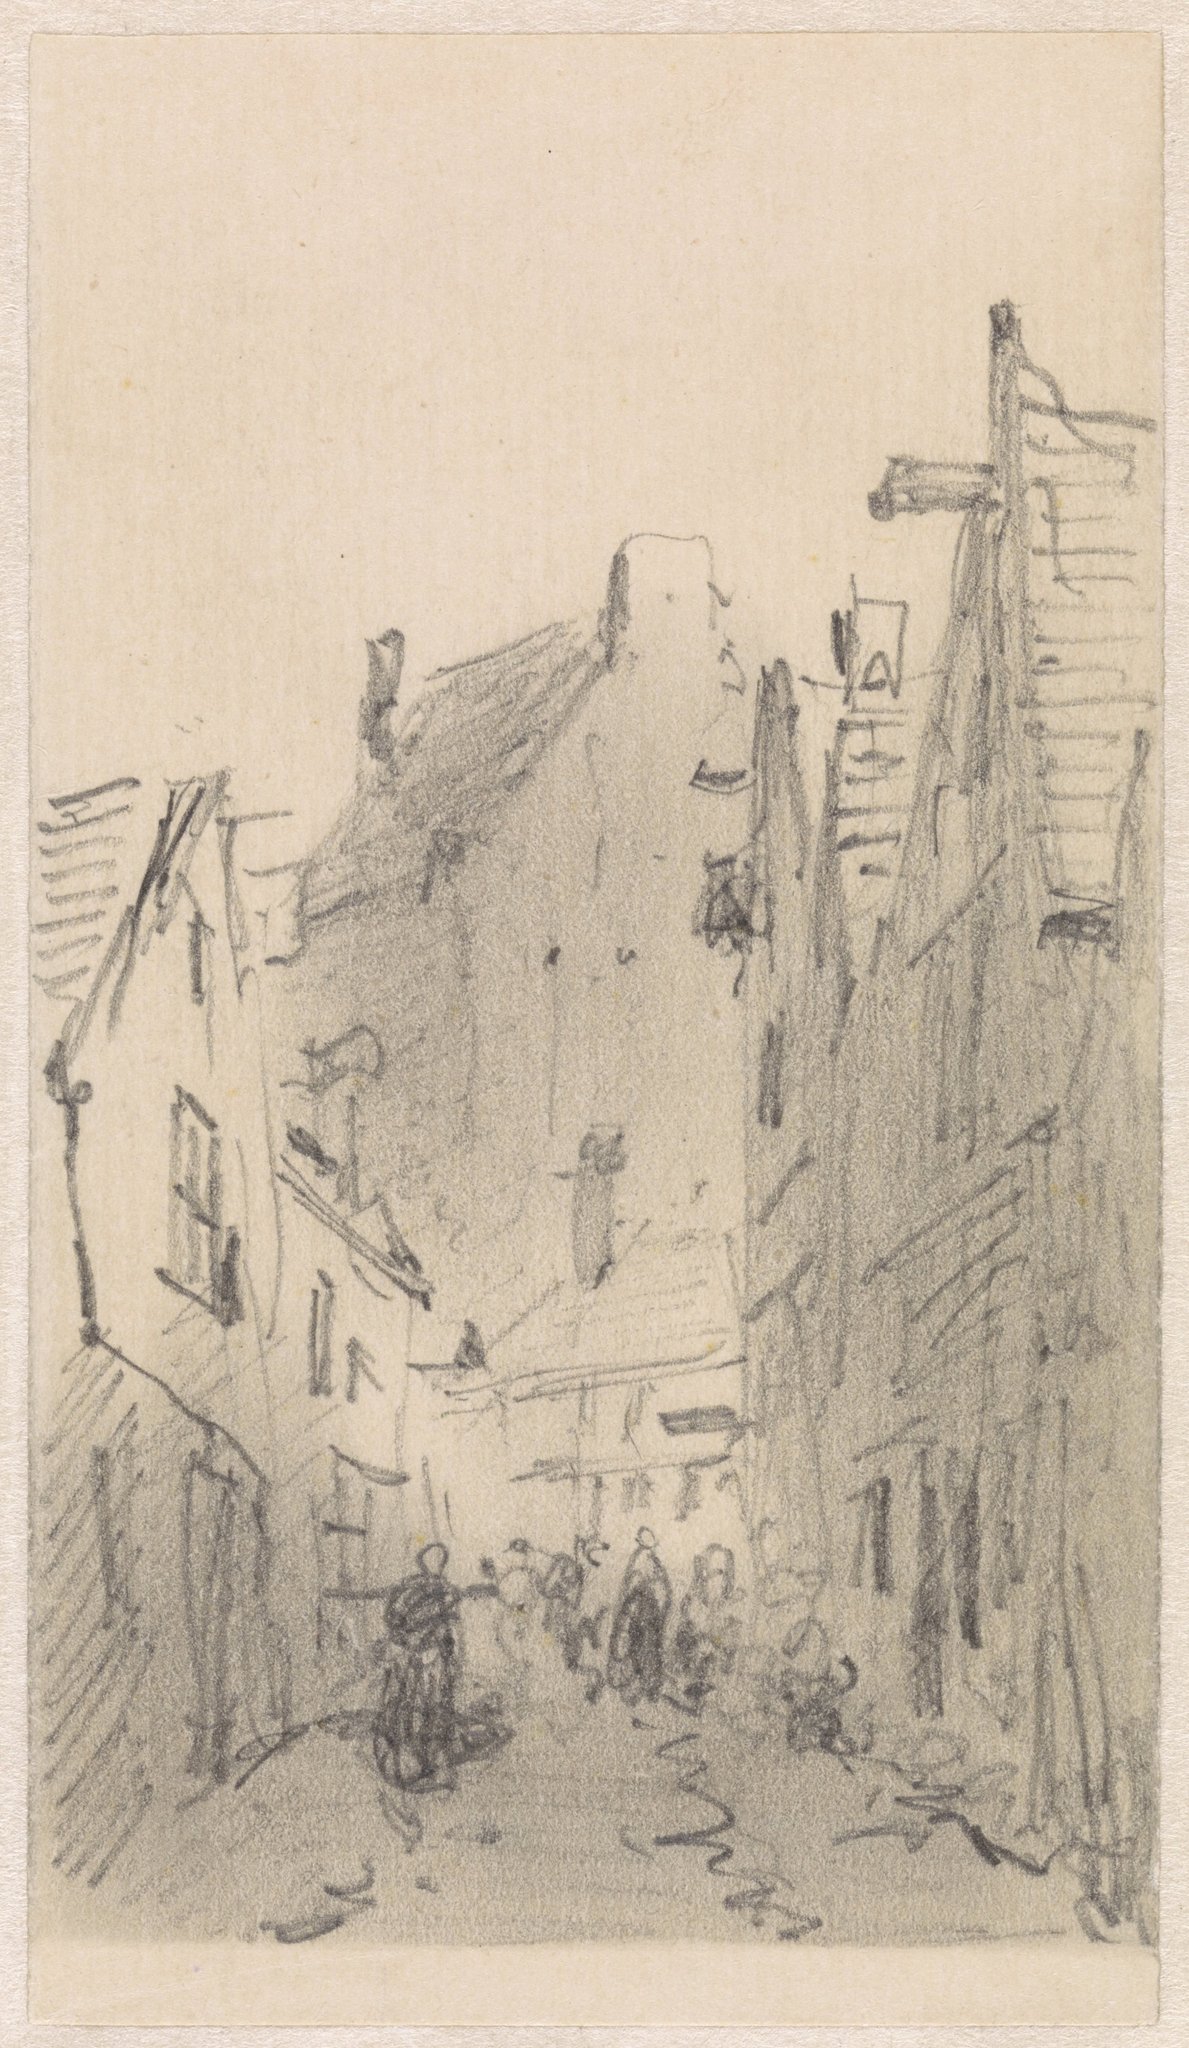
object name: drawing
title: Stadsgezicht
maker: adrianus eversen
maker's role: draughtsman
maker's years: 1818-1897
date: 1828-1897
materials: paper, pencil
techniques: stumping